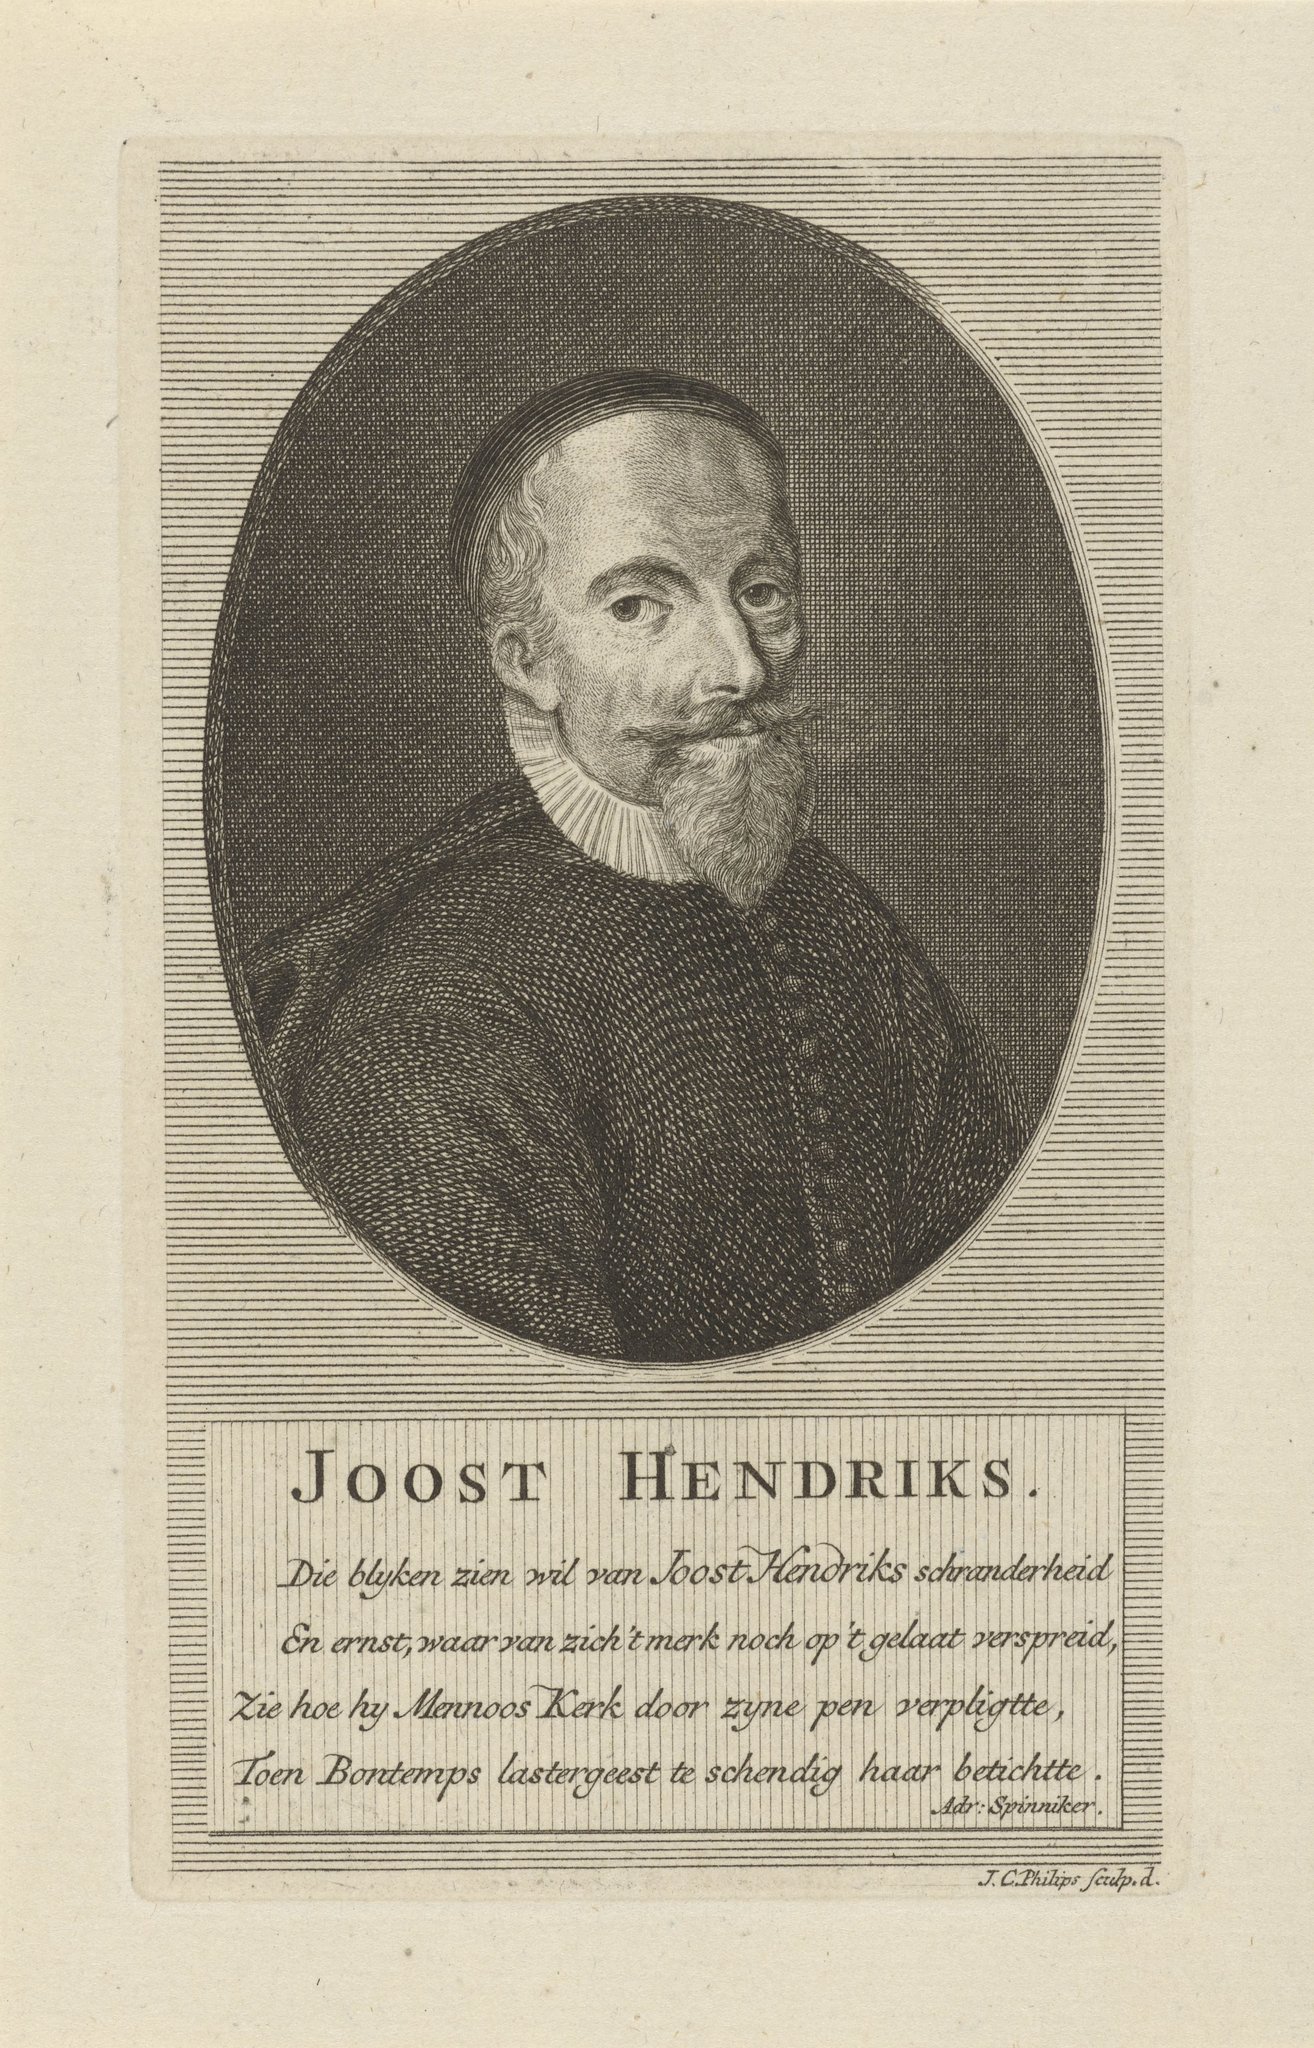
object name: print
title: Portret van de doopsgezinde predikant Joost Hendriksz.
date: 1736-1743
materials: paper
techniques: engraving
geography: amsterdam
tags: harlingen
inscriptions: collector's mark: Lugt 2228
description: Portret van de doopsgezinde predikant Joost Hendriksz. In het kader een vierregelig lofdicht in het Nederlands.